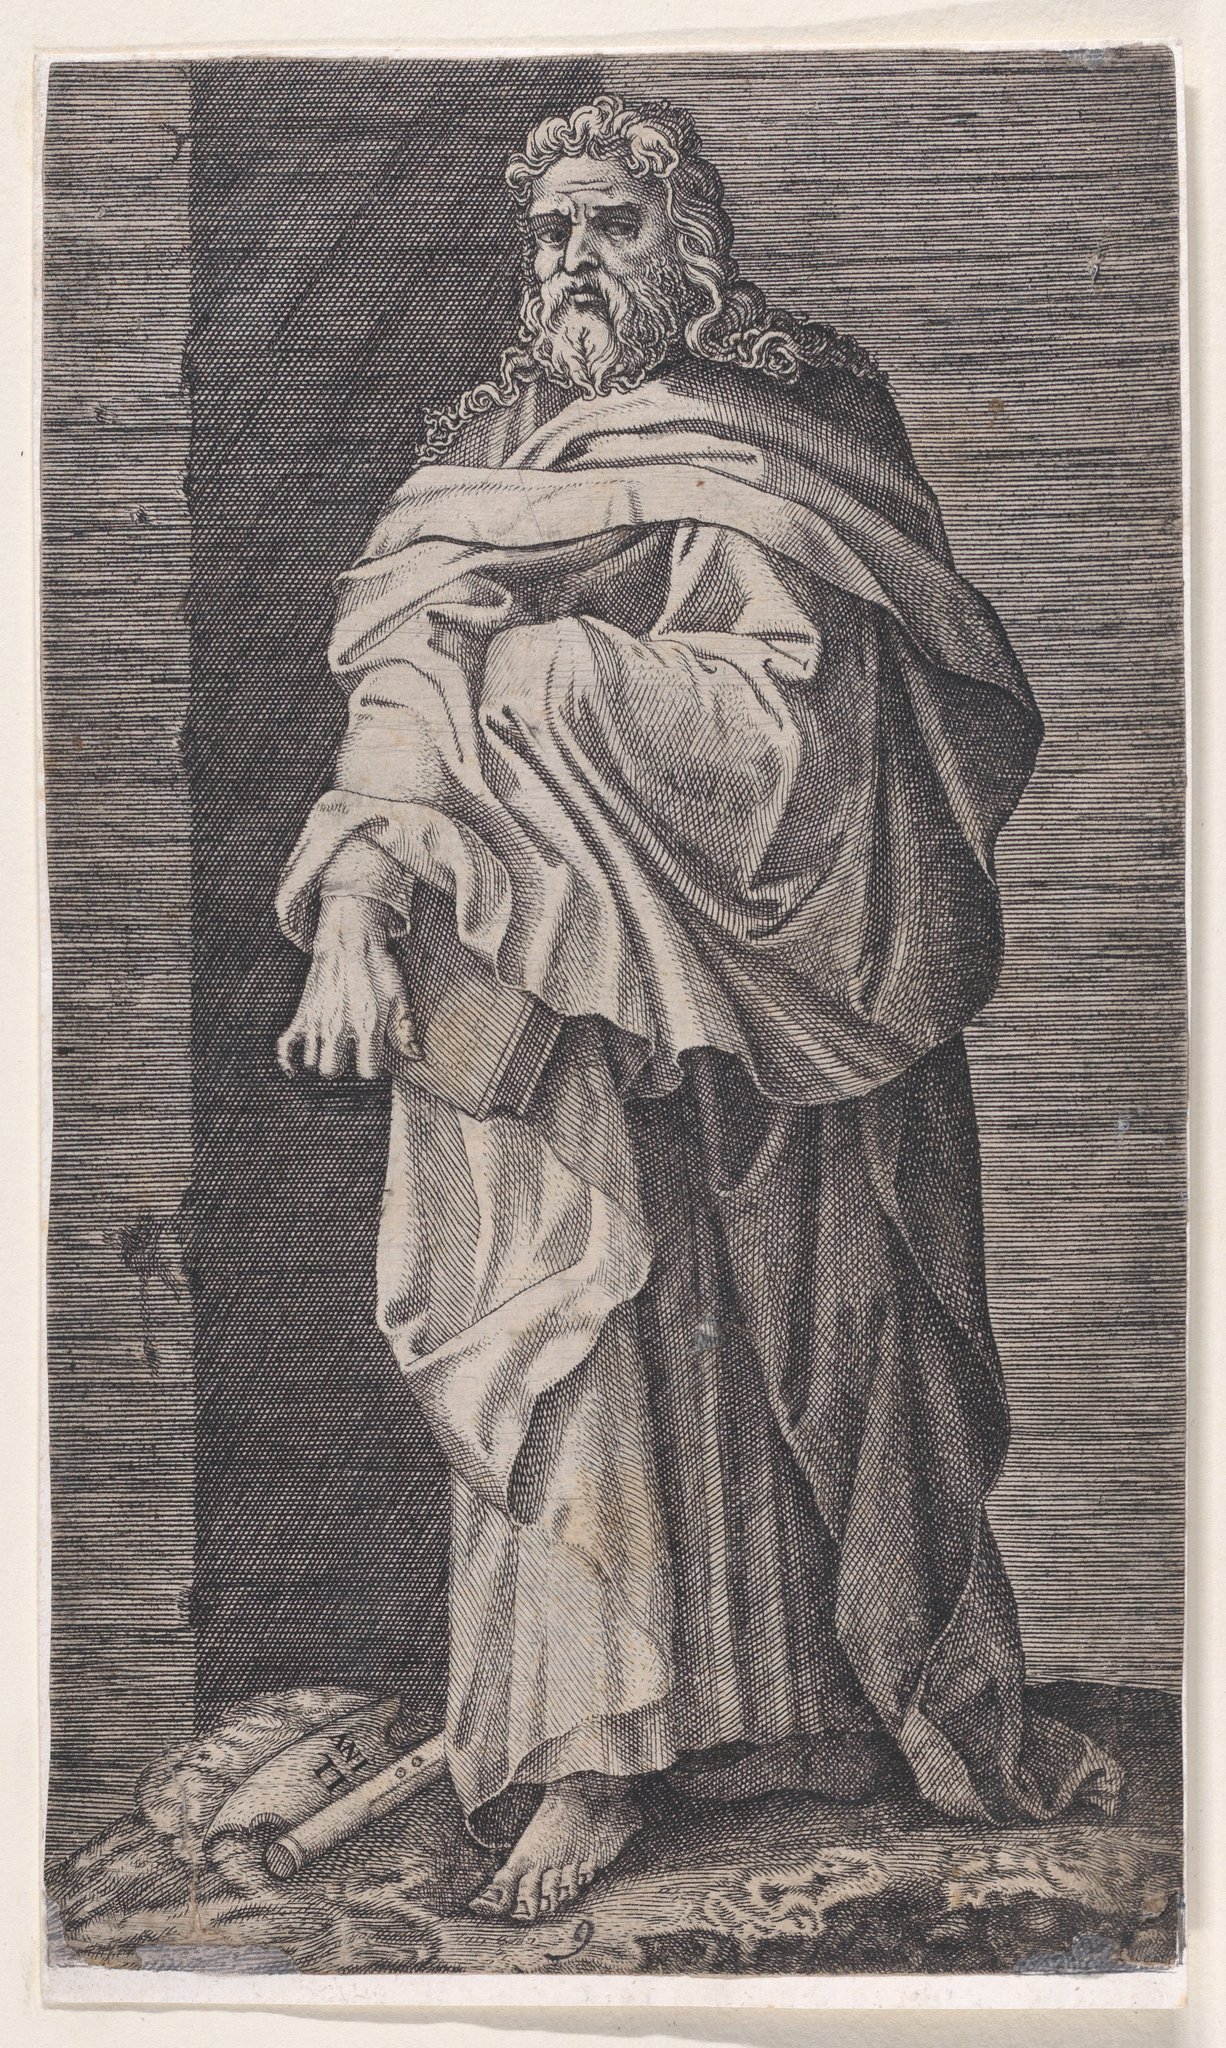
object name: print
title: St. Matthias, from "Christ and the Apostles"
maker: lambert suavius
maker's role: artist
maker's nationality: netherlandish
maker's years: 1510-1576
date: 1530-1576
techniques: backing, engraving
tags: men,saints